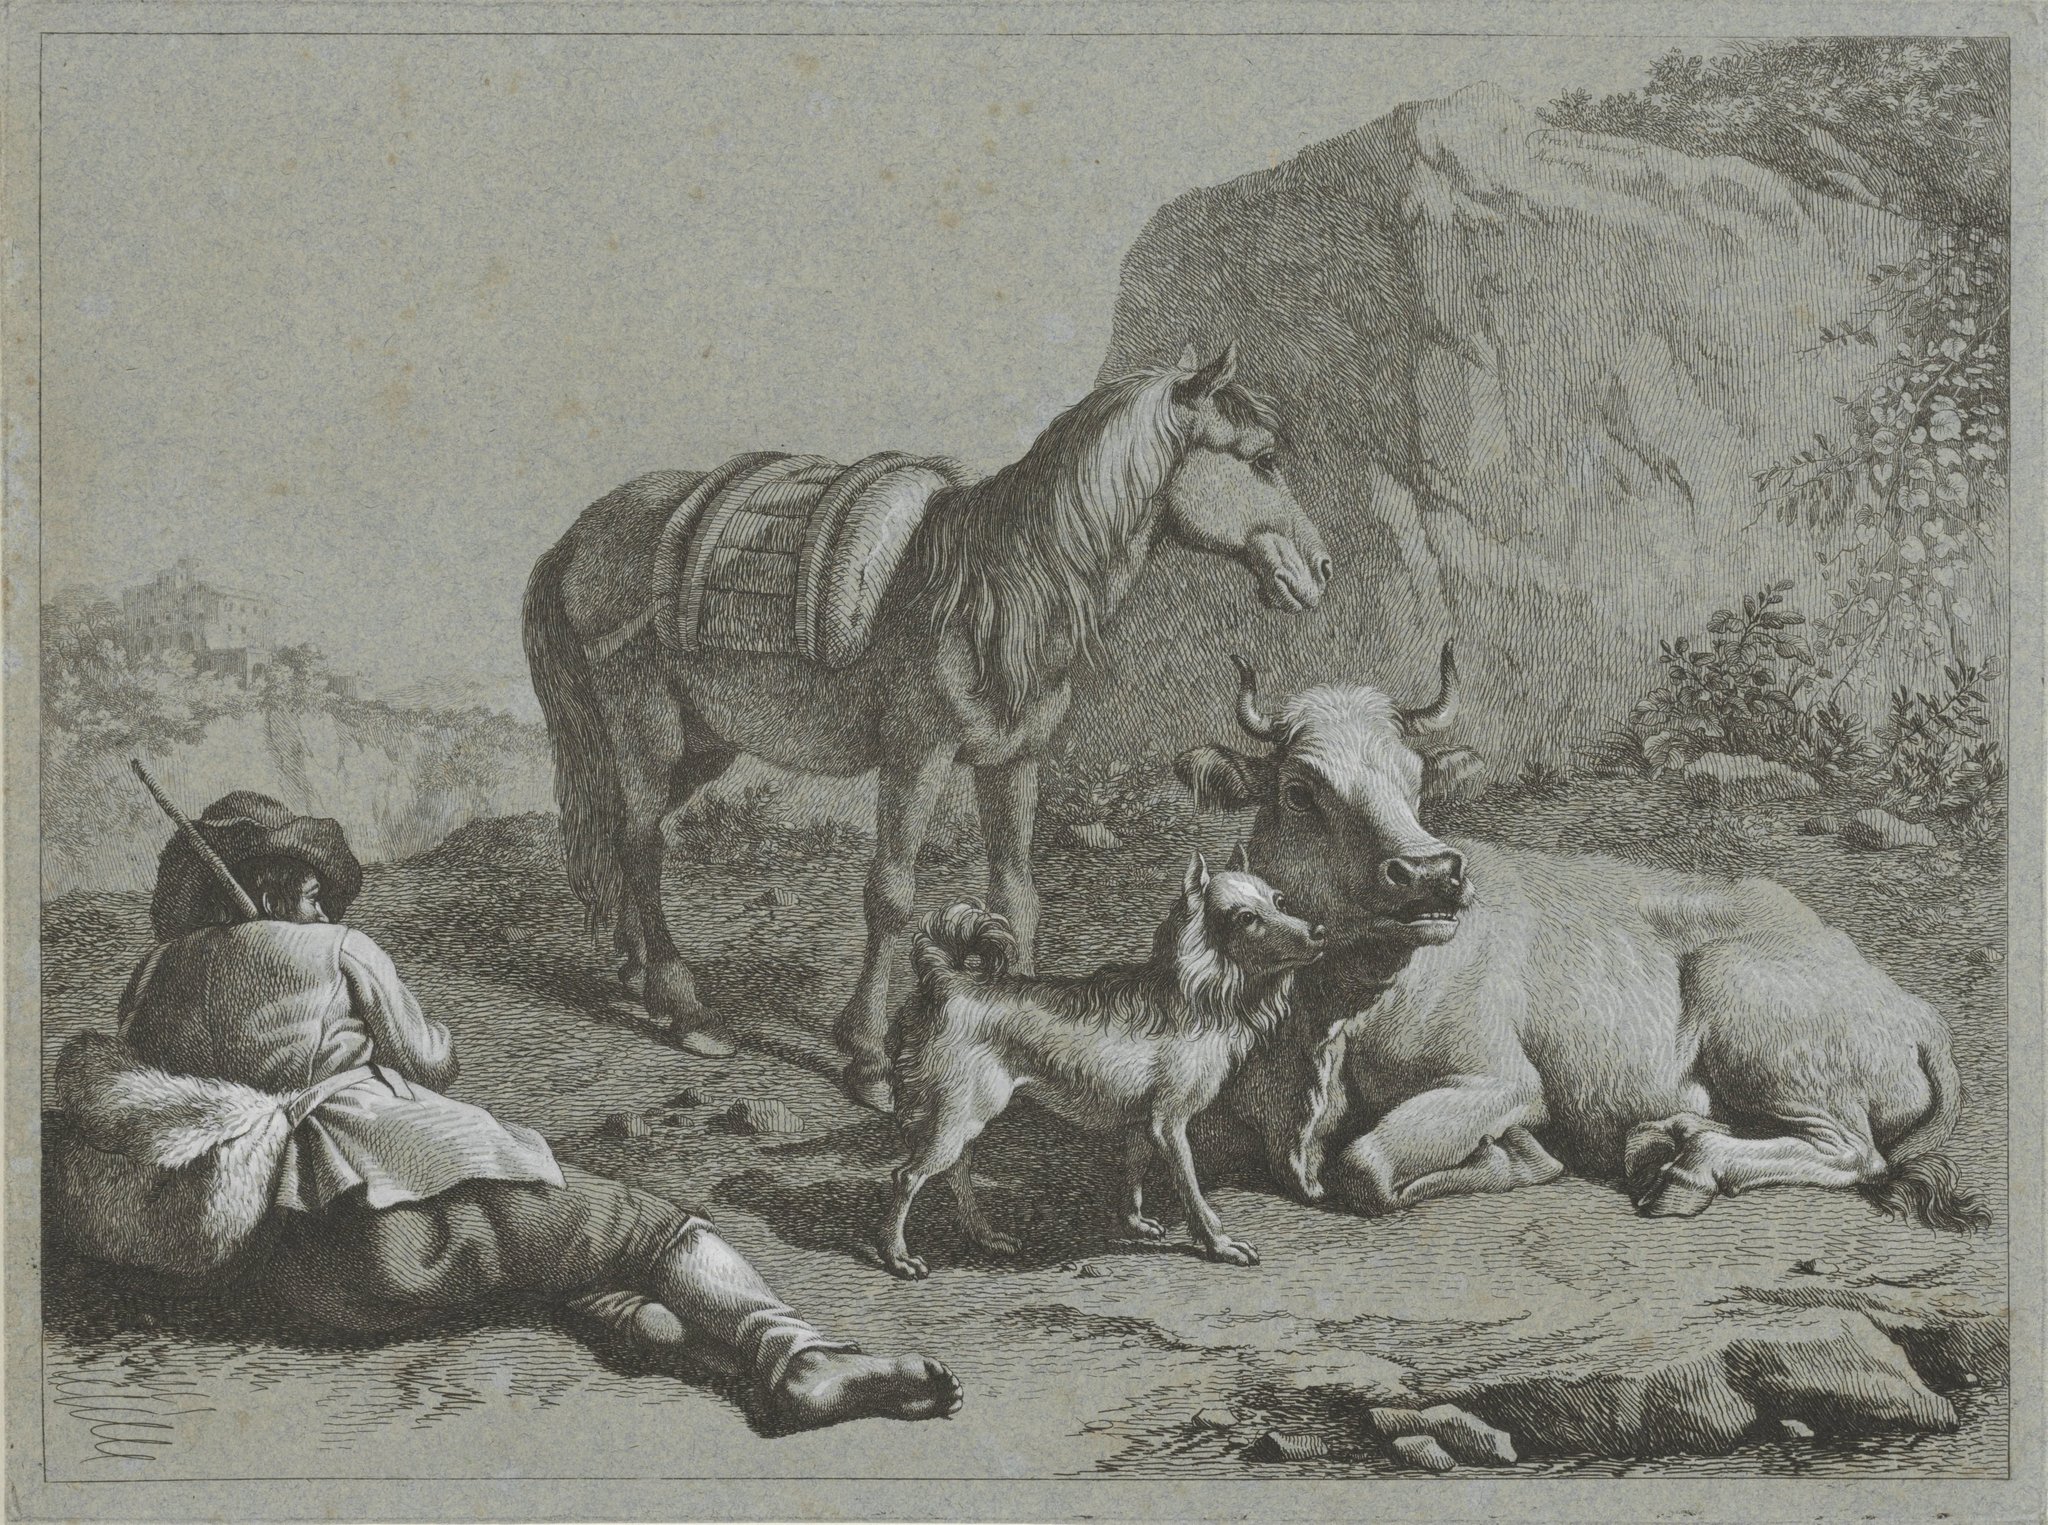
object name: print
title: Liggende herder met paard, koe en hond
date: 1763-1764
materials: paper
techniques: etching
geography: italy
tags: cow, herding, herdsman, herdswoman, shepherd, shepherdess, cowherd, etc., horse, dog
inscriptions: collector's mark: Lugt 240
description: Een liggende herder, op de rug gezien, in een landschap met een paard, een hond en een koe.